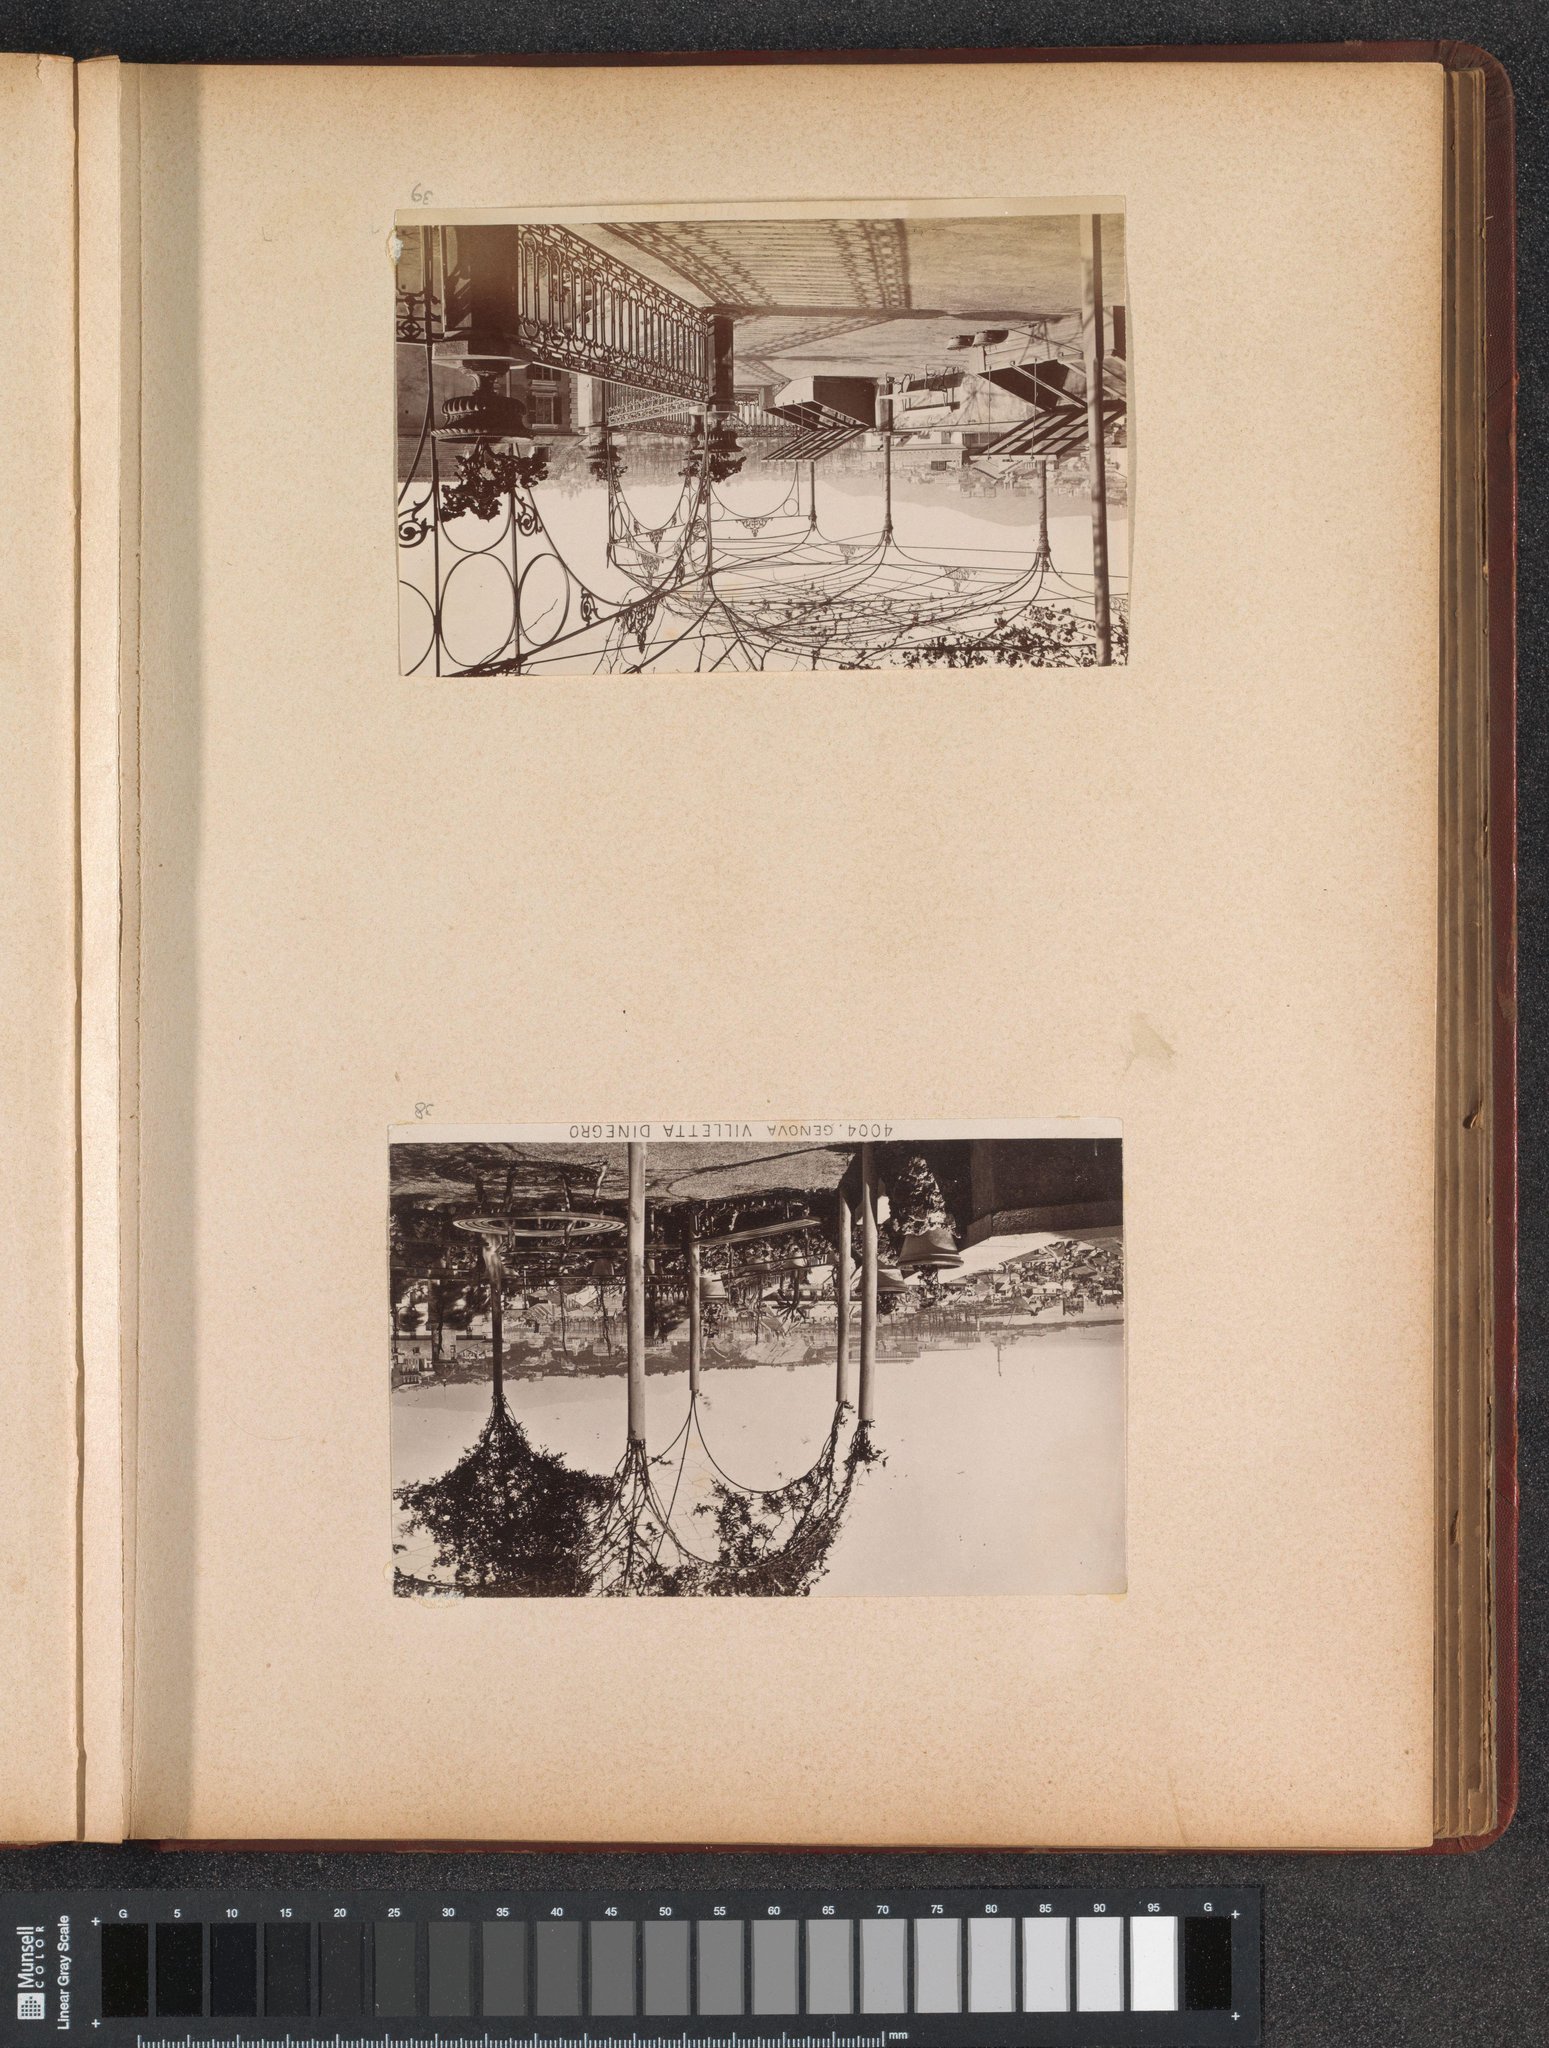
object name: album leaf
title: Terras met pergola's, vermoedelijk Viletta Dinegro in Genua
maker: Anonymous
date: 1870-1900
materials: paper, photographic support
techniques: albumen print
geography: genoa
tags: villa, public gardens, park, prospect of city, town panorama, silhouette of city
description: Onderdeel van Reisalbum met foto's van bezienswaardigheden in Italië en Zuid-Frankrijk.